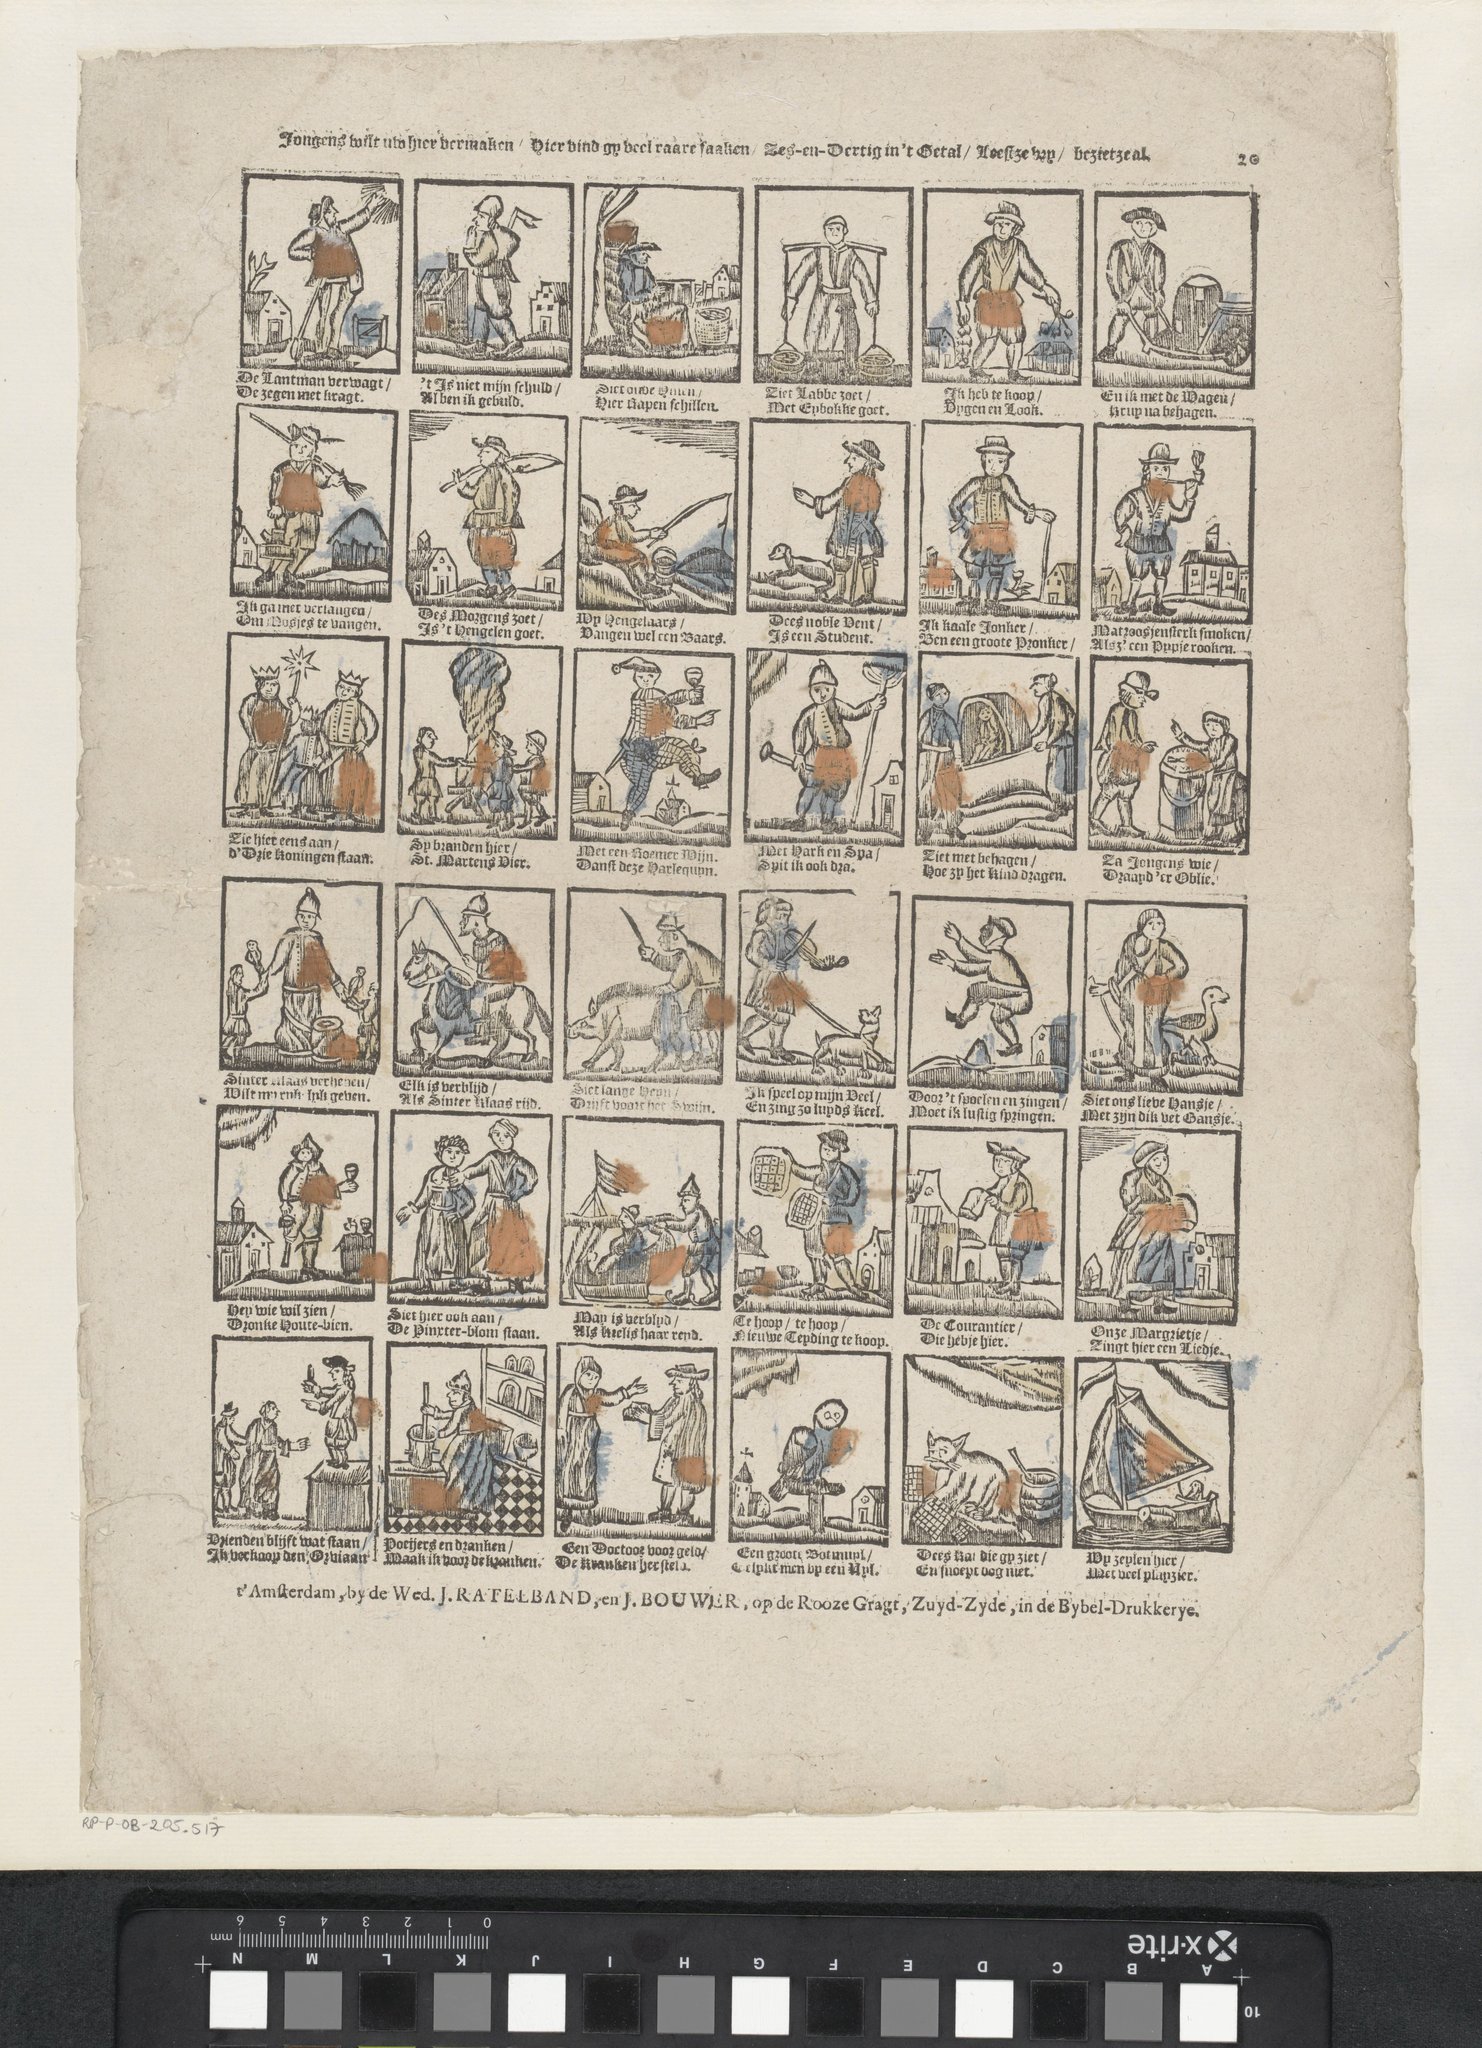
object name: popular print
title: Jongens wilt uw hier vermaken / Hier vind gy heel raare saaken / Zes-en-dertig in 't getal / Leest ze vry / Beziet ze al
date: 1767-1778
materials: paper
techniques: colour, letterpress printing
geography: amsterdam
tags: human types, fool, simpleton, numskull, street-trader, hunchback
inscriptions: collector's mark: Lugt 2760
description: Blad met 36 voorstellingen van verschillende figuren en bezigheden. Onder elke afbeelding een tweeregelig vers. Genummerd rechtsboven: 20.